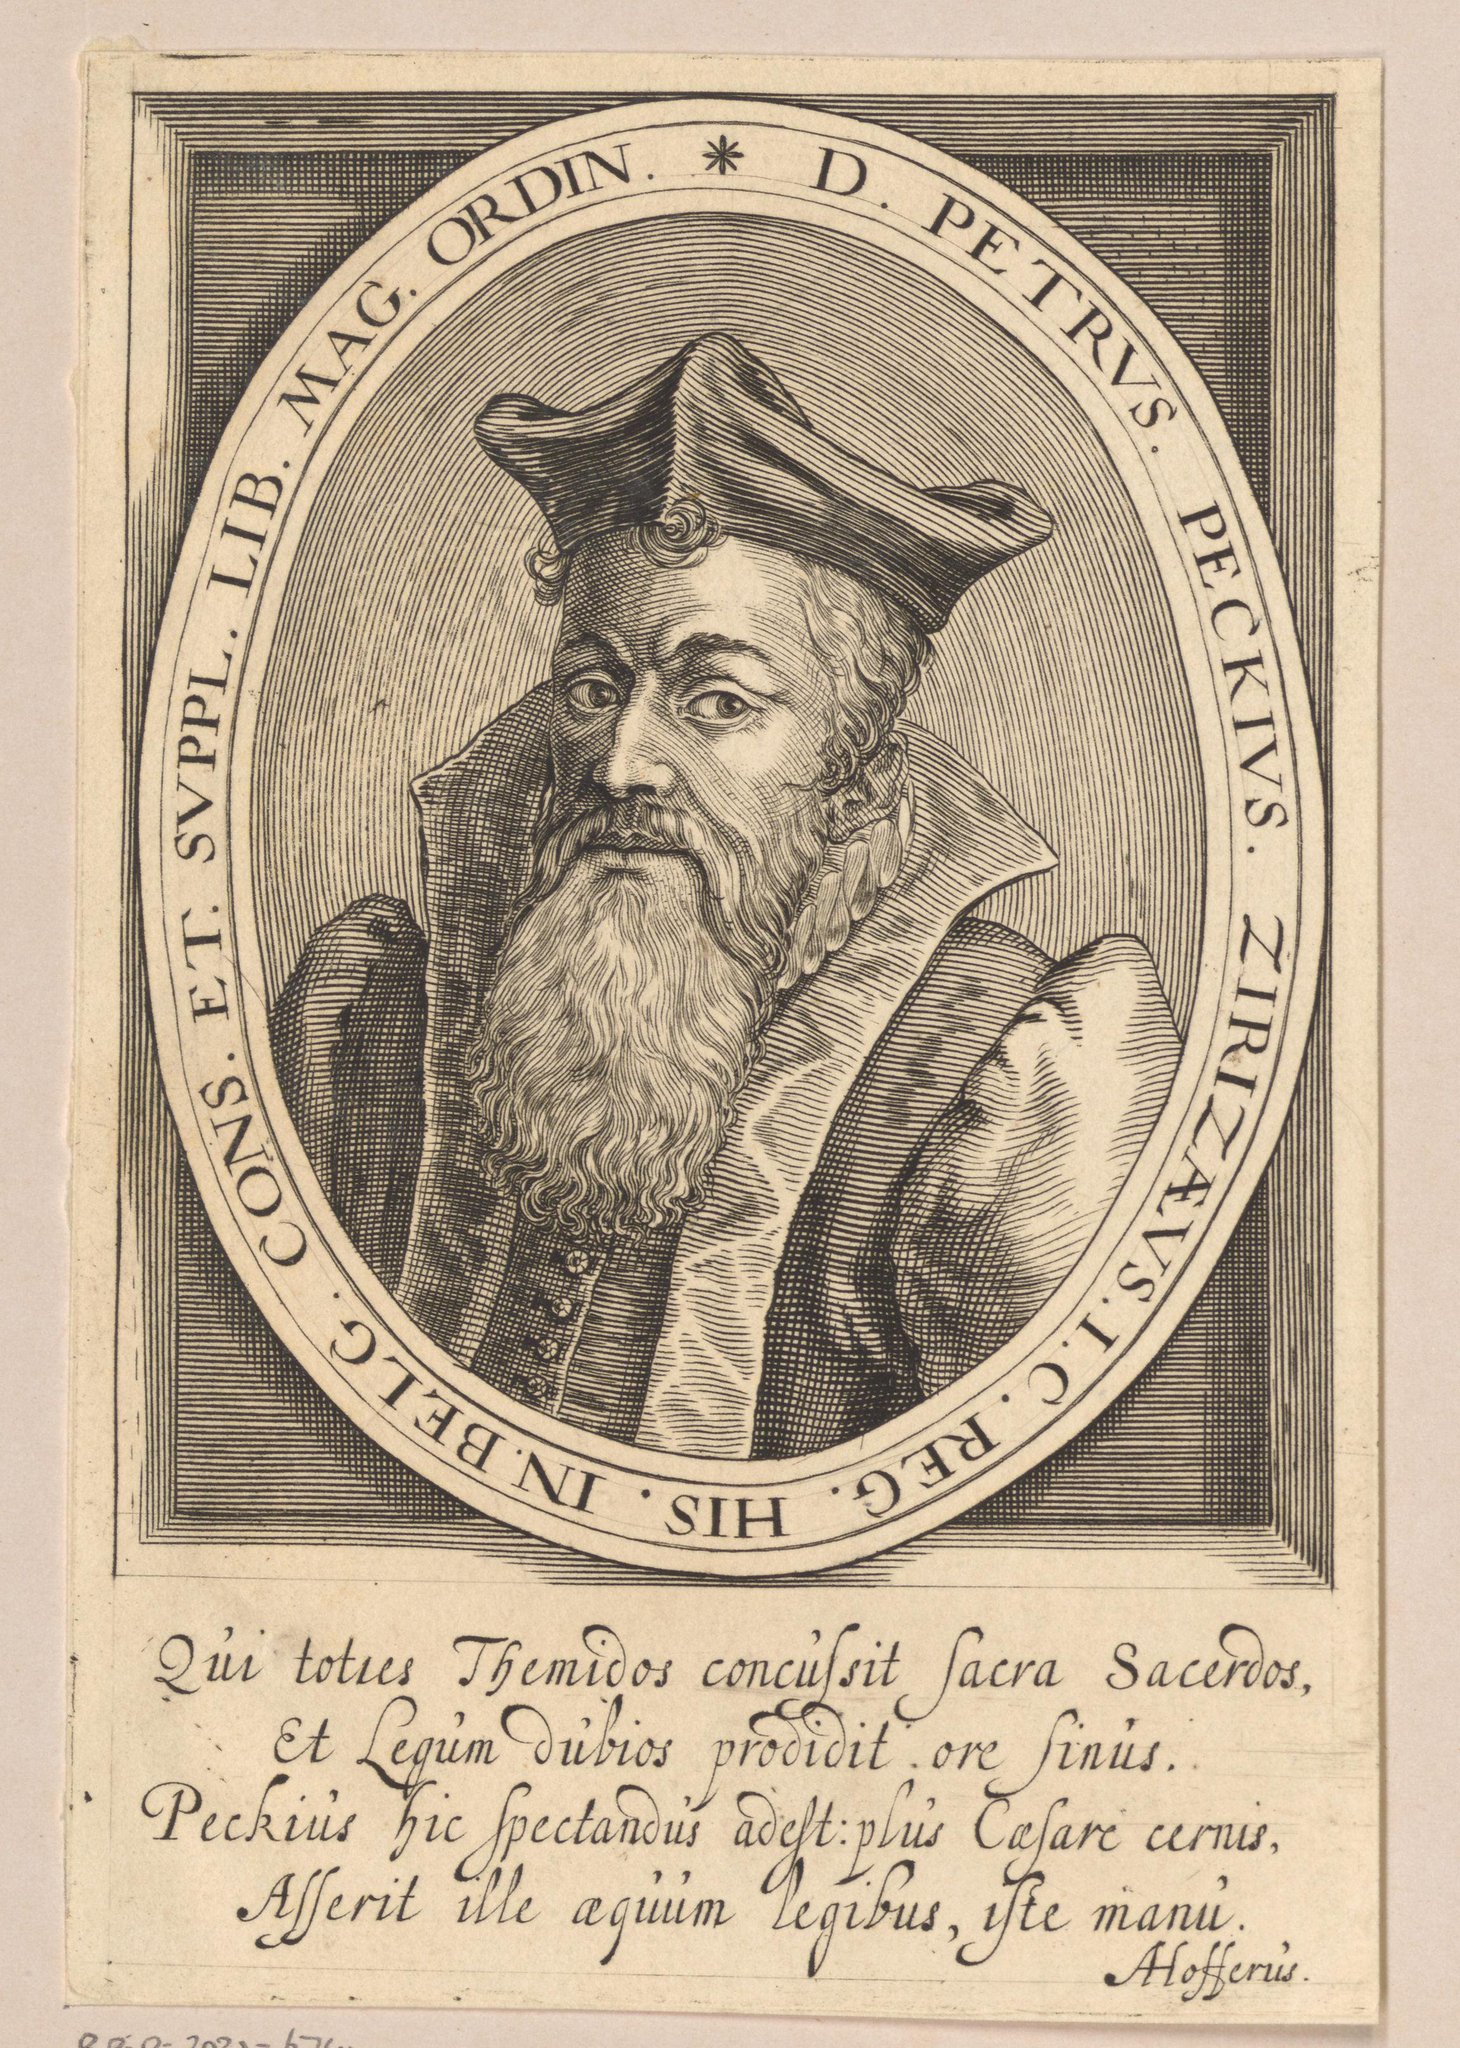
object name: print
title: Portret van Pieter Peck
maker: Anonymous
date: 1582-1649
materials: paper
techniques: engraving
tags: mechelen, adult man, historical persons